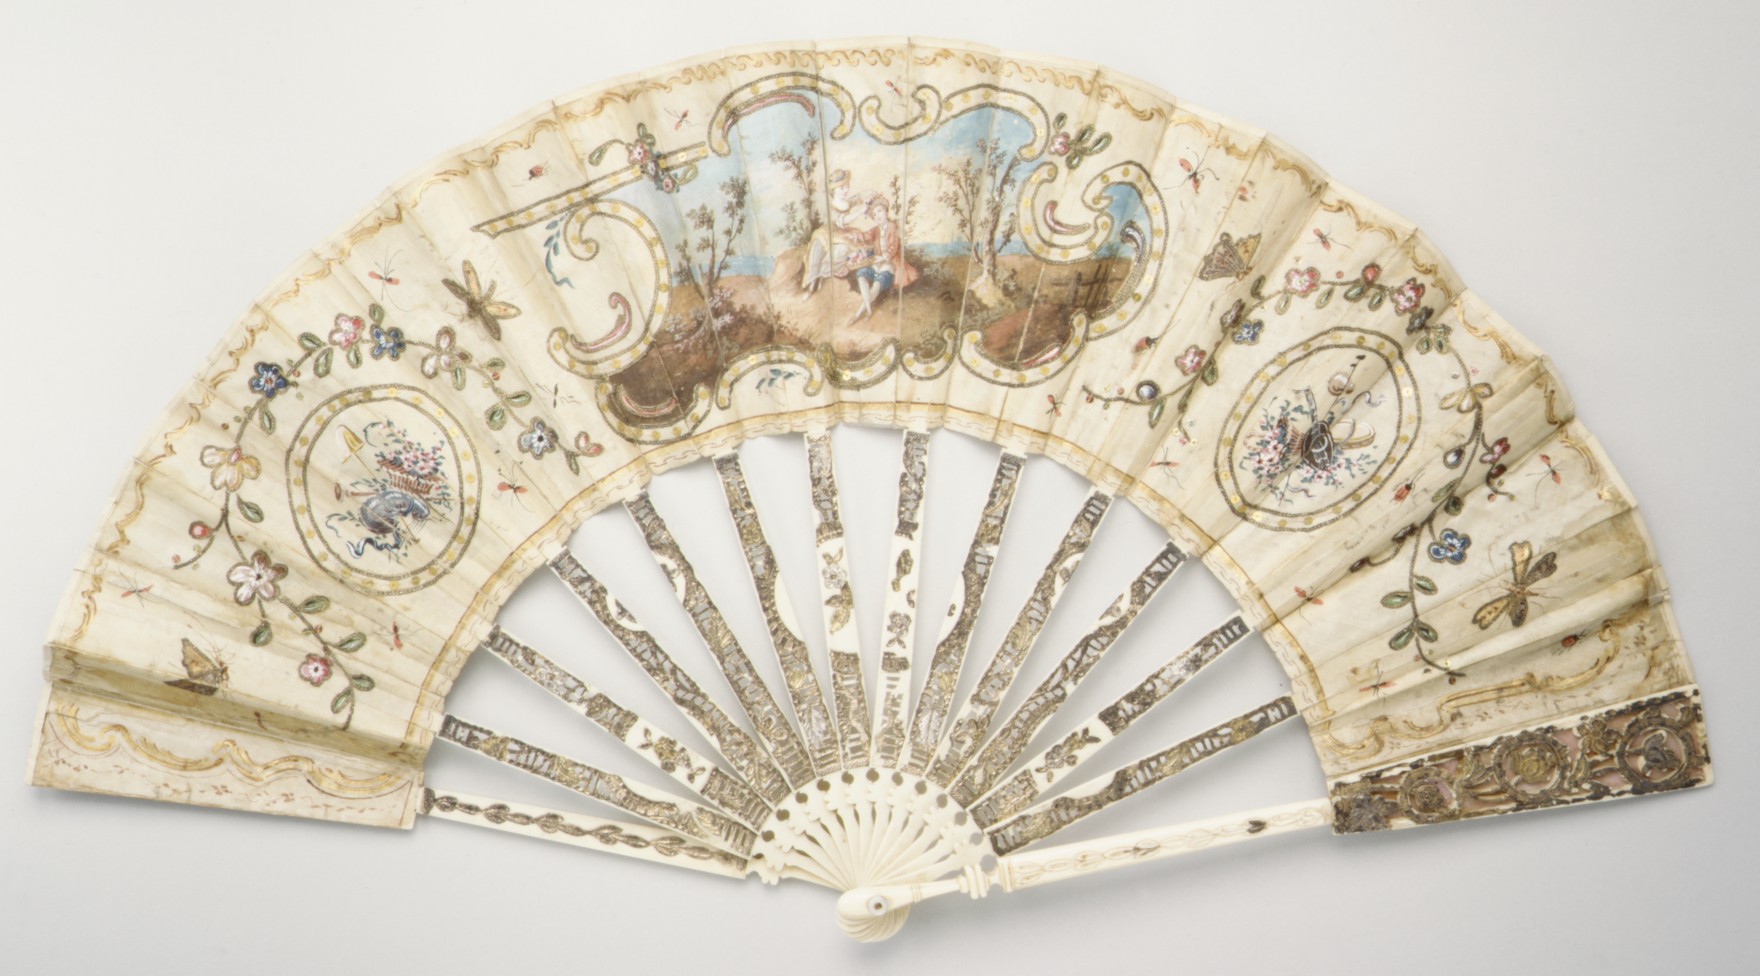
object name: fan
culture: french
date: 1701-1800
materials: ivory, linen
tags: men,women,flowers